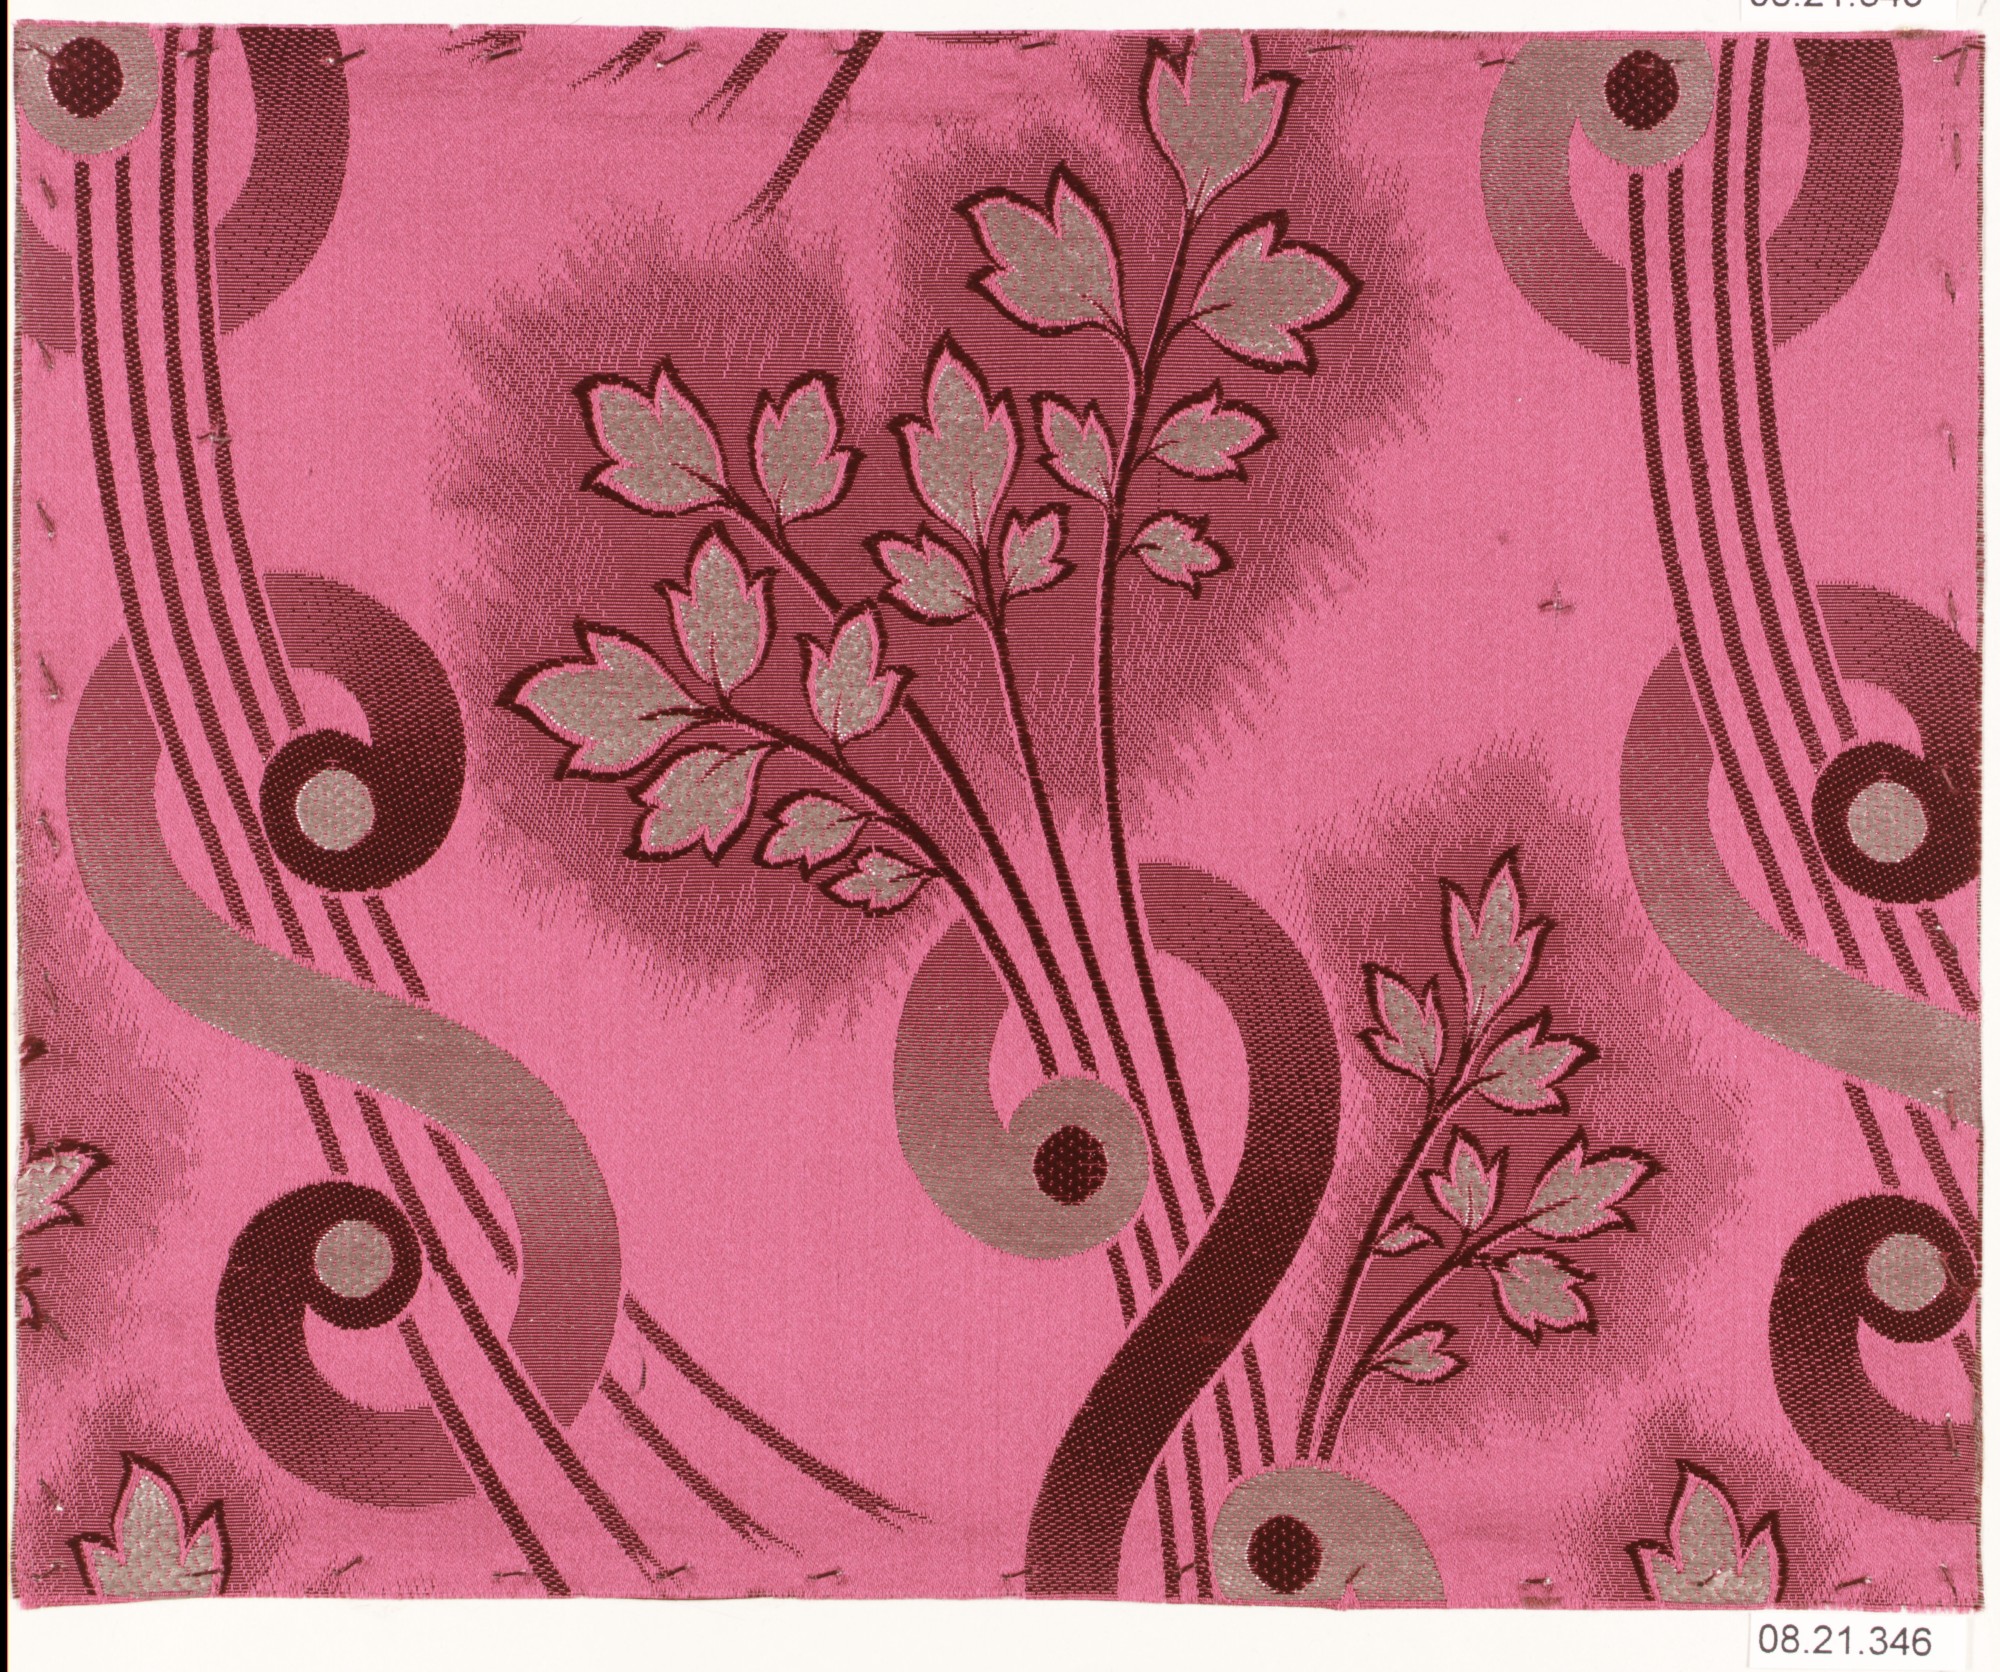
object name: textile sample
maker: Anonymous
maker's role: designer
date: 1900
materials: silk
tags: leaves